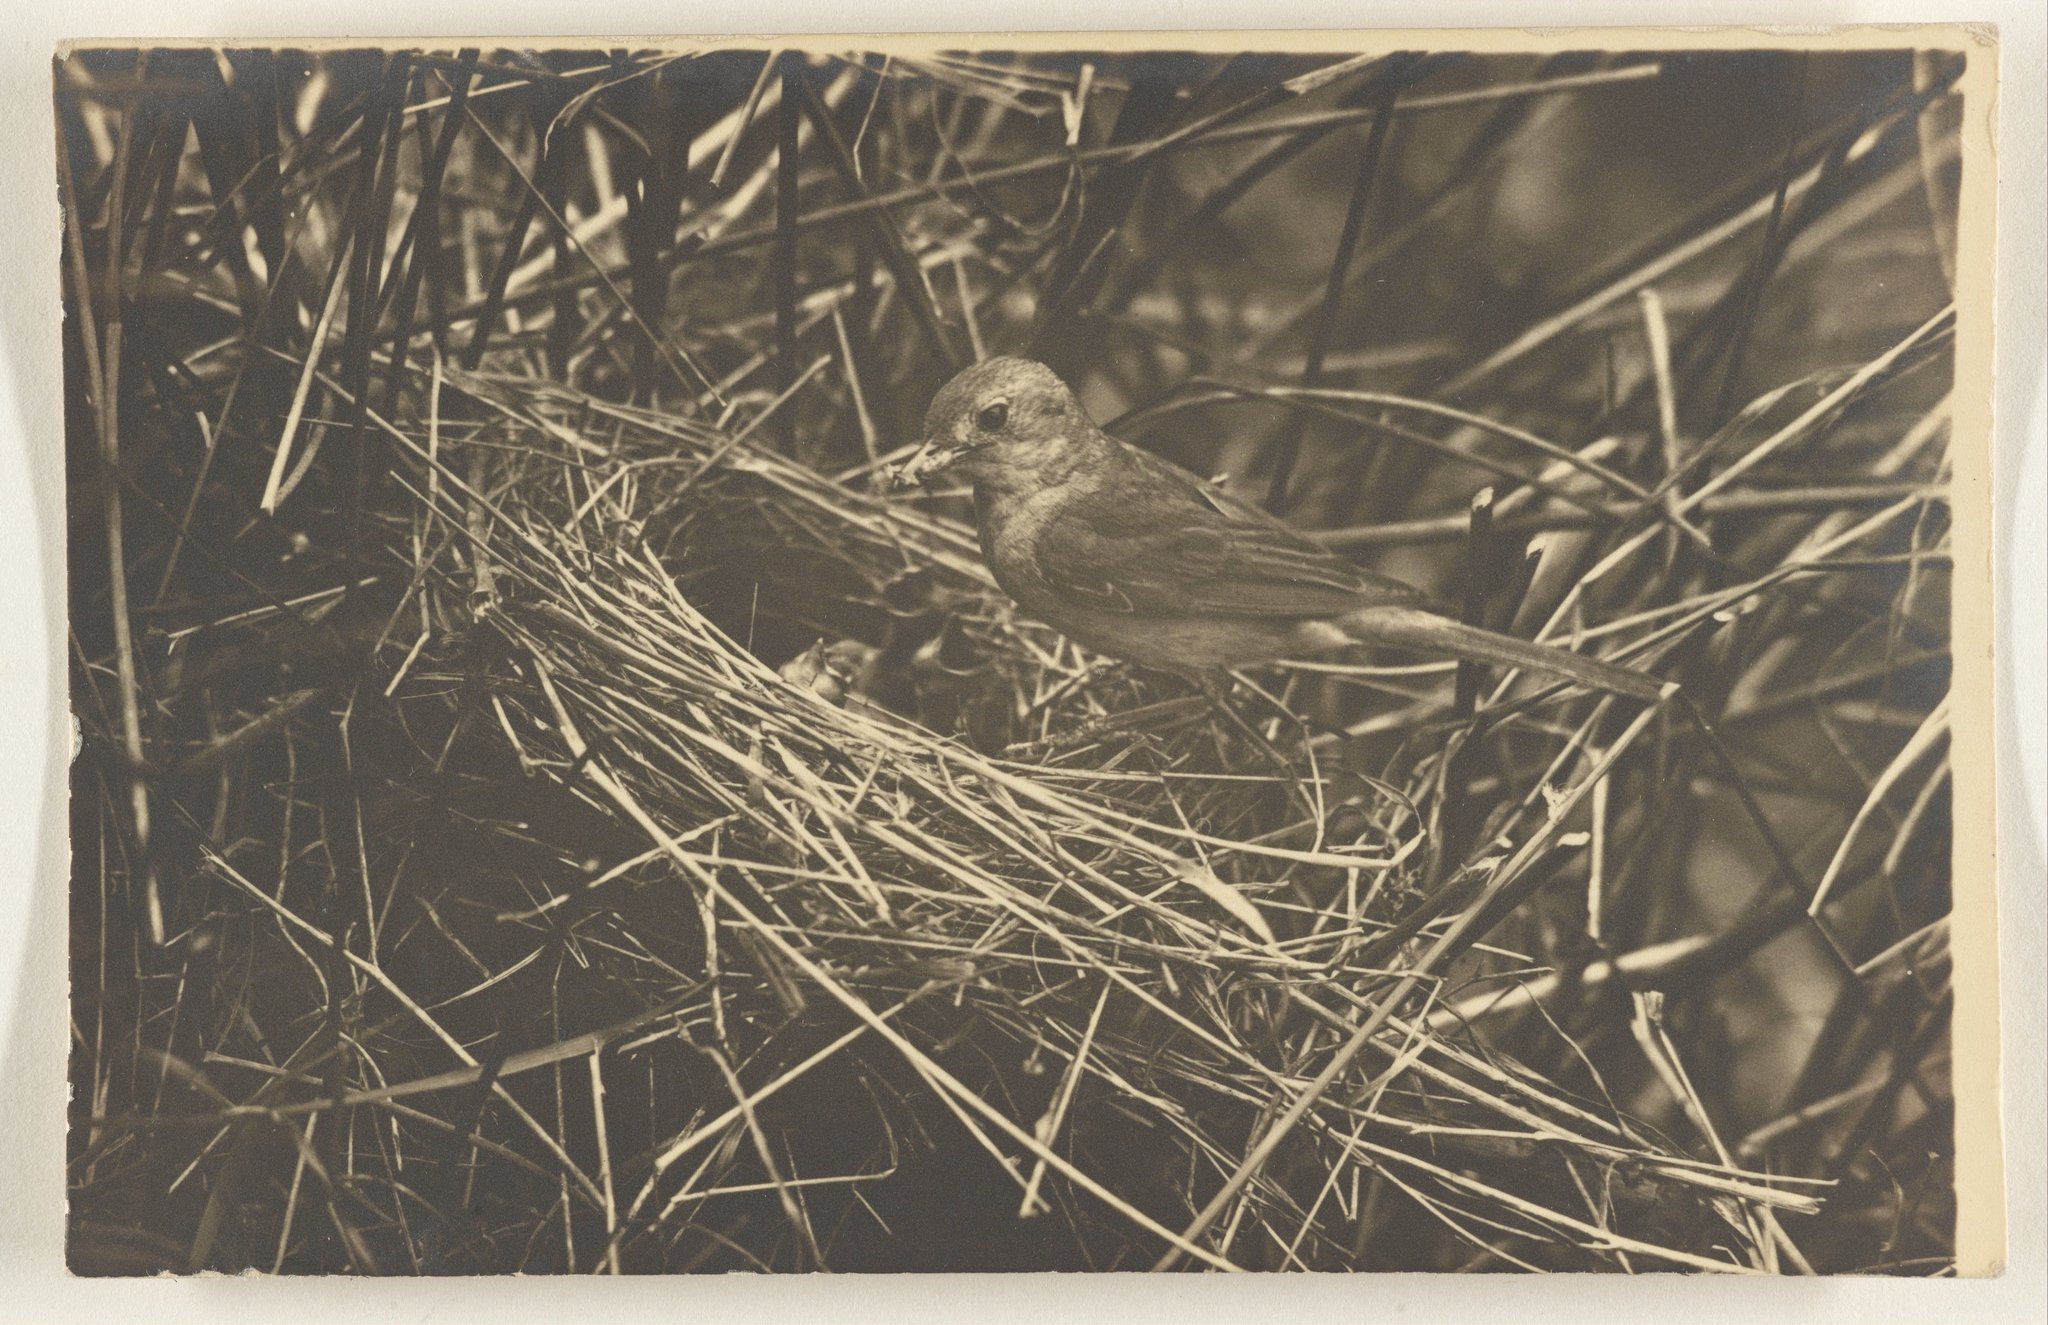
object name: photograph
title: Vogel op nest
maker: richard tepe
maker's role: fotograaf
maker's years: 1864-1952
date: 1900-1930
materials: paper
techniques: gelatin silver print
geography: netherlands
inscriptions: mark: ‘T&M [= Trapp & Münch]’